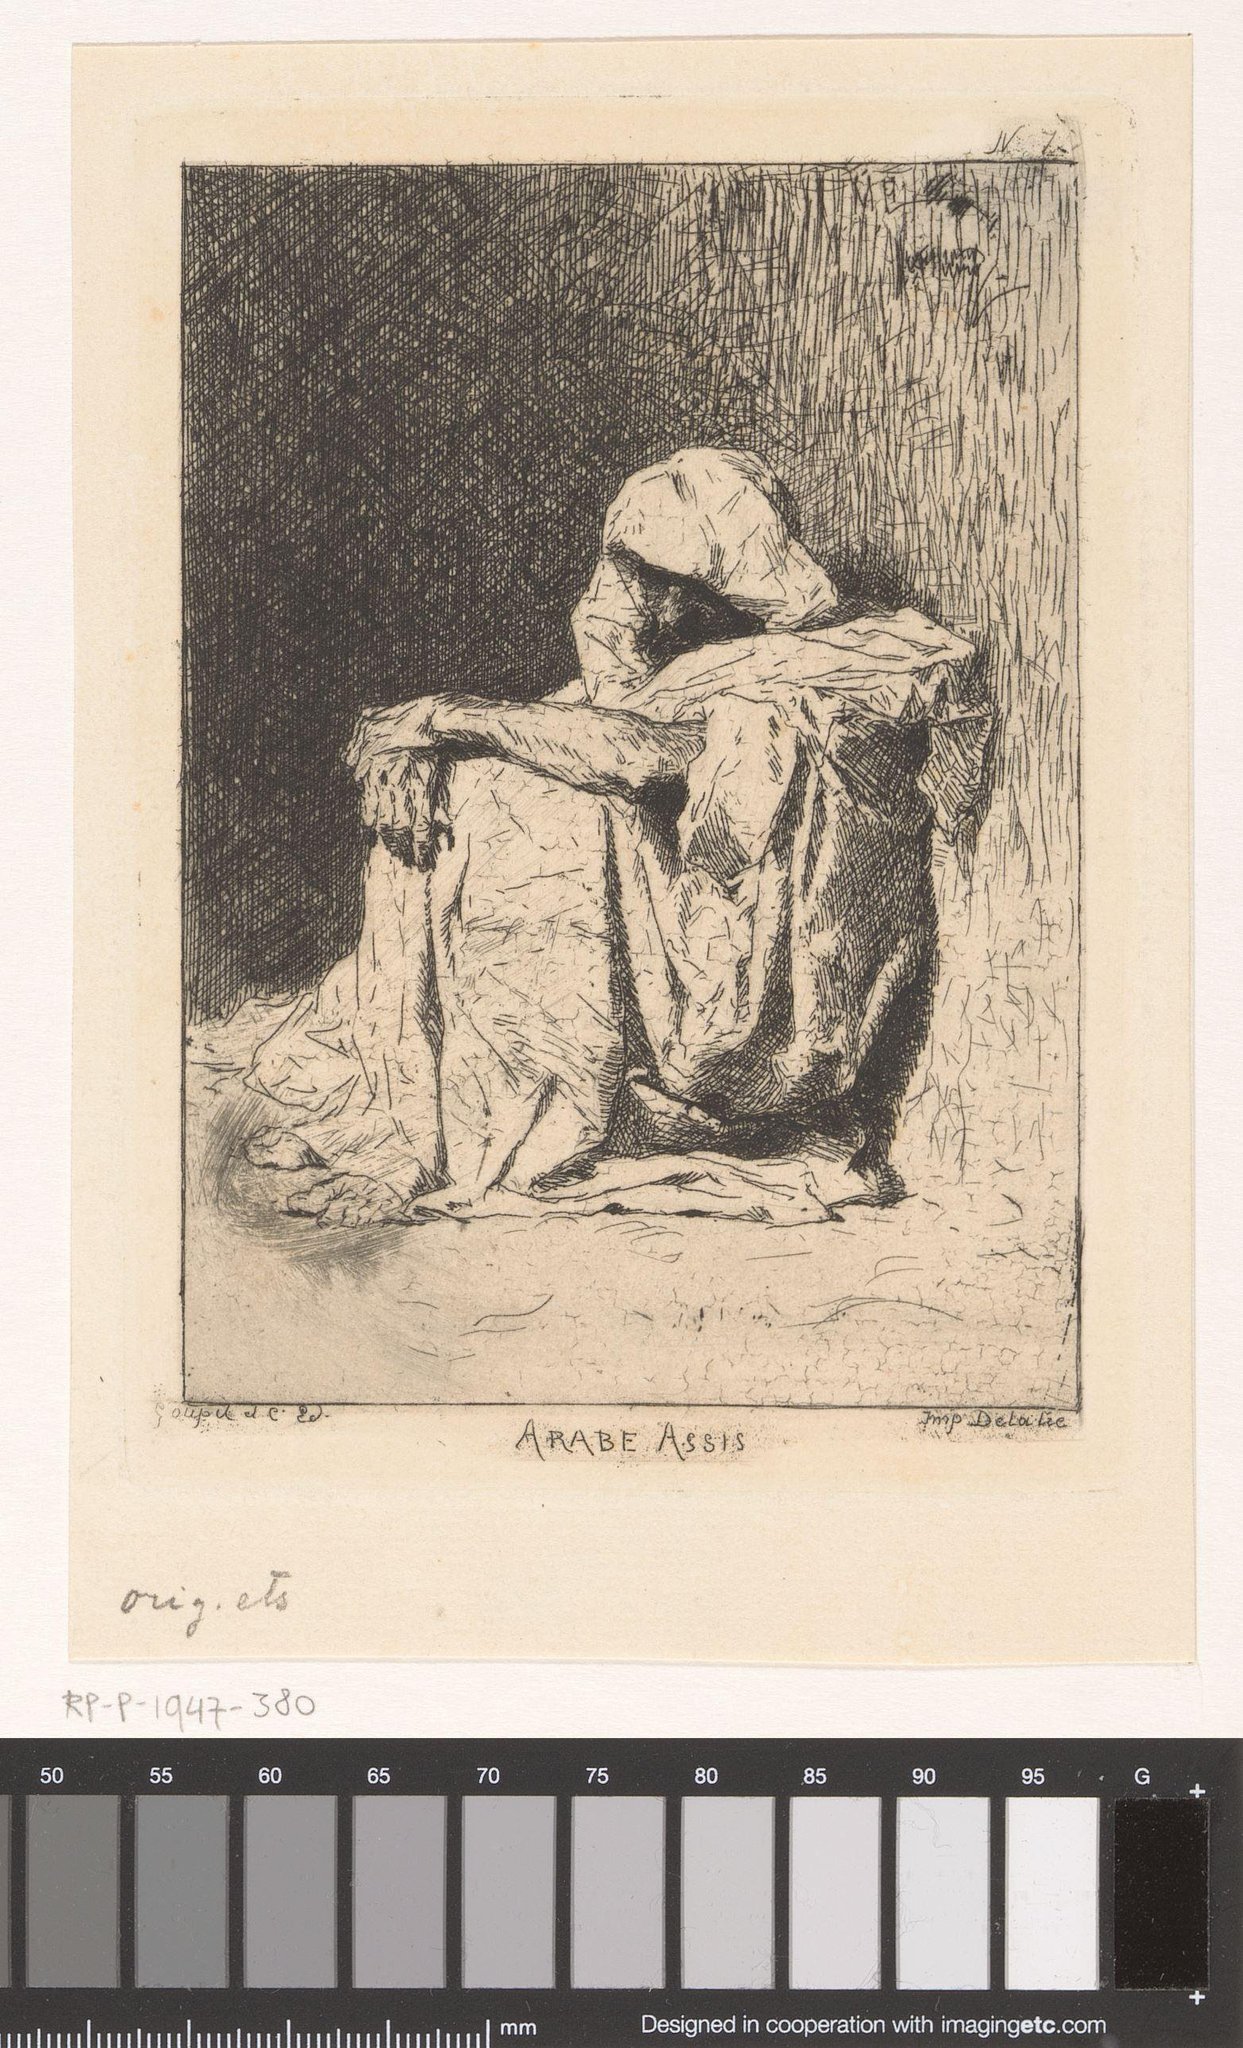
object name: print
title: Zittende Arabische man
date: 1848-1874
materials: paper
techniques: etching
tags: sitting on the ground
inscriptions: collector's mark: Lugt 2228